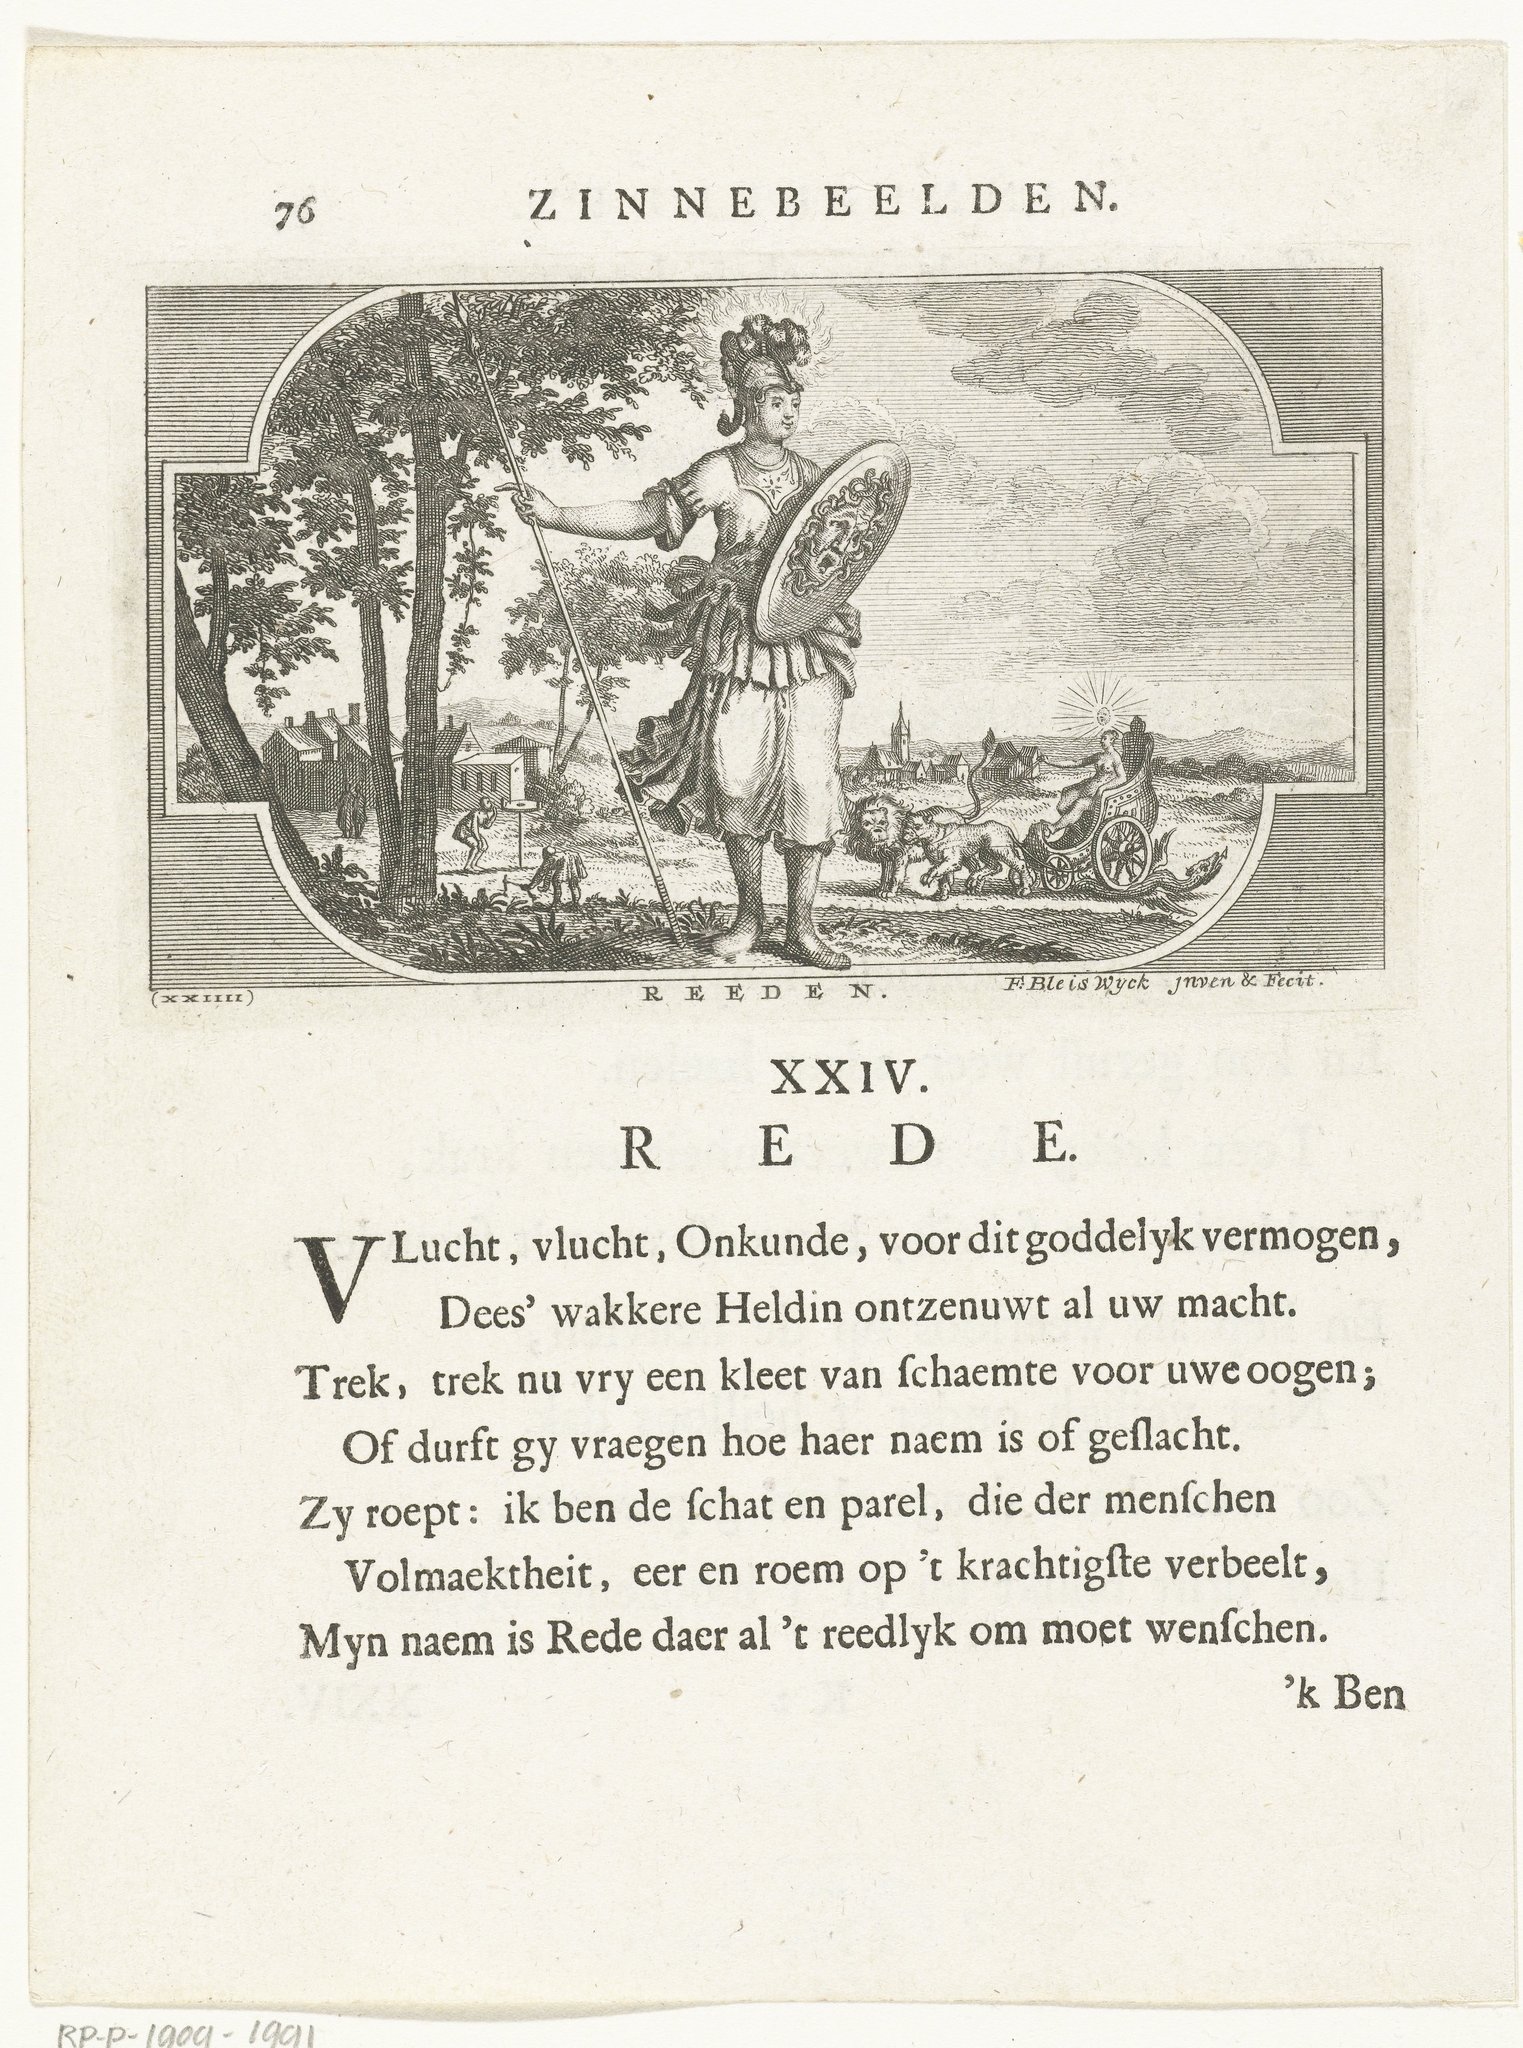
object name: book illustration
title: Embleem met allegorie op verstand (rede)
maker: françois van bleyswijck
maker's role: draughtsman, print maker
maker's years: 1671-1746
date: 1681-1737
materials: paper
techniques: etching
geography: leiden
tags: reason; 'ragione' (ripa)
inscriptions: collector's mark: Lugt 2228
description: Embleem met allegorie op verstand (rede) verbeeld als vrouw met wapenrusting die bestaat uit helm, schild en lans. In een landschap rijdt een vrouw in een rijtuig getrokken door leeuw en leeuwin, de wielen vermorzelen een monster. Onder de voorstelling staat een gedicht, op het verso staat een gedeelte van een ander gedicht.